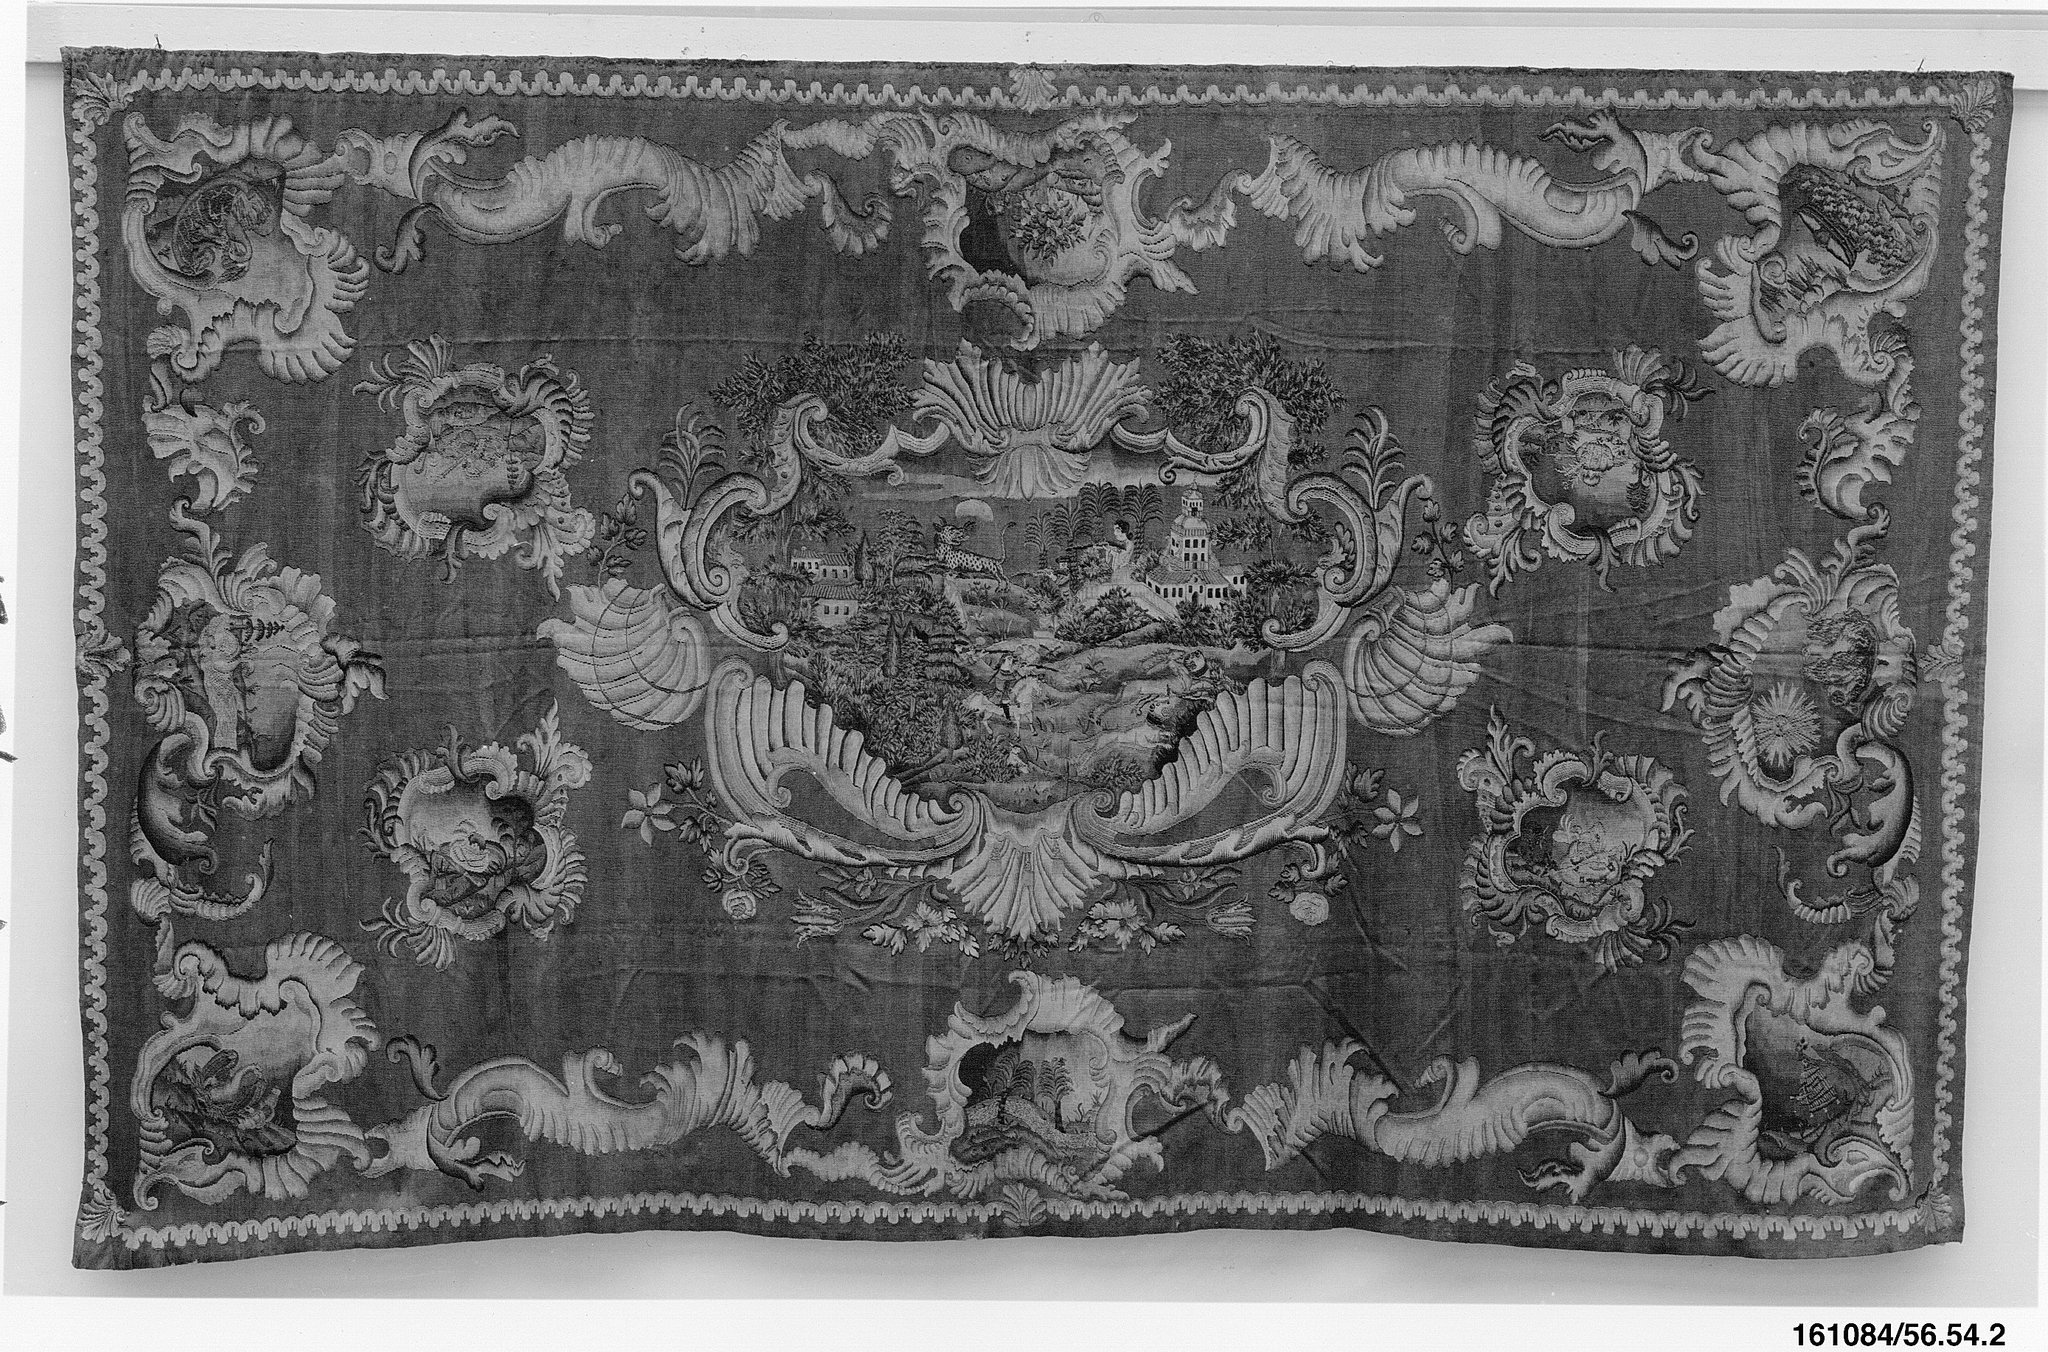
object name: table carpet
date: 1760-1775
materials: wool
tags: hunting,horses